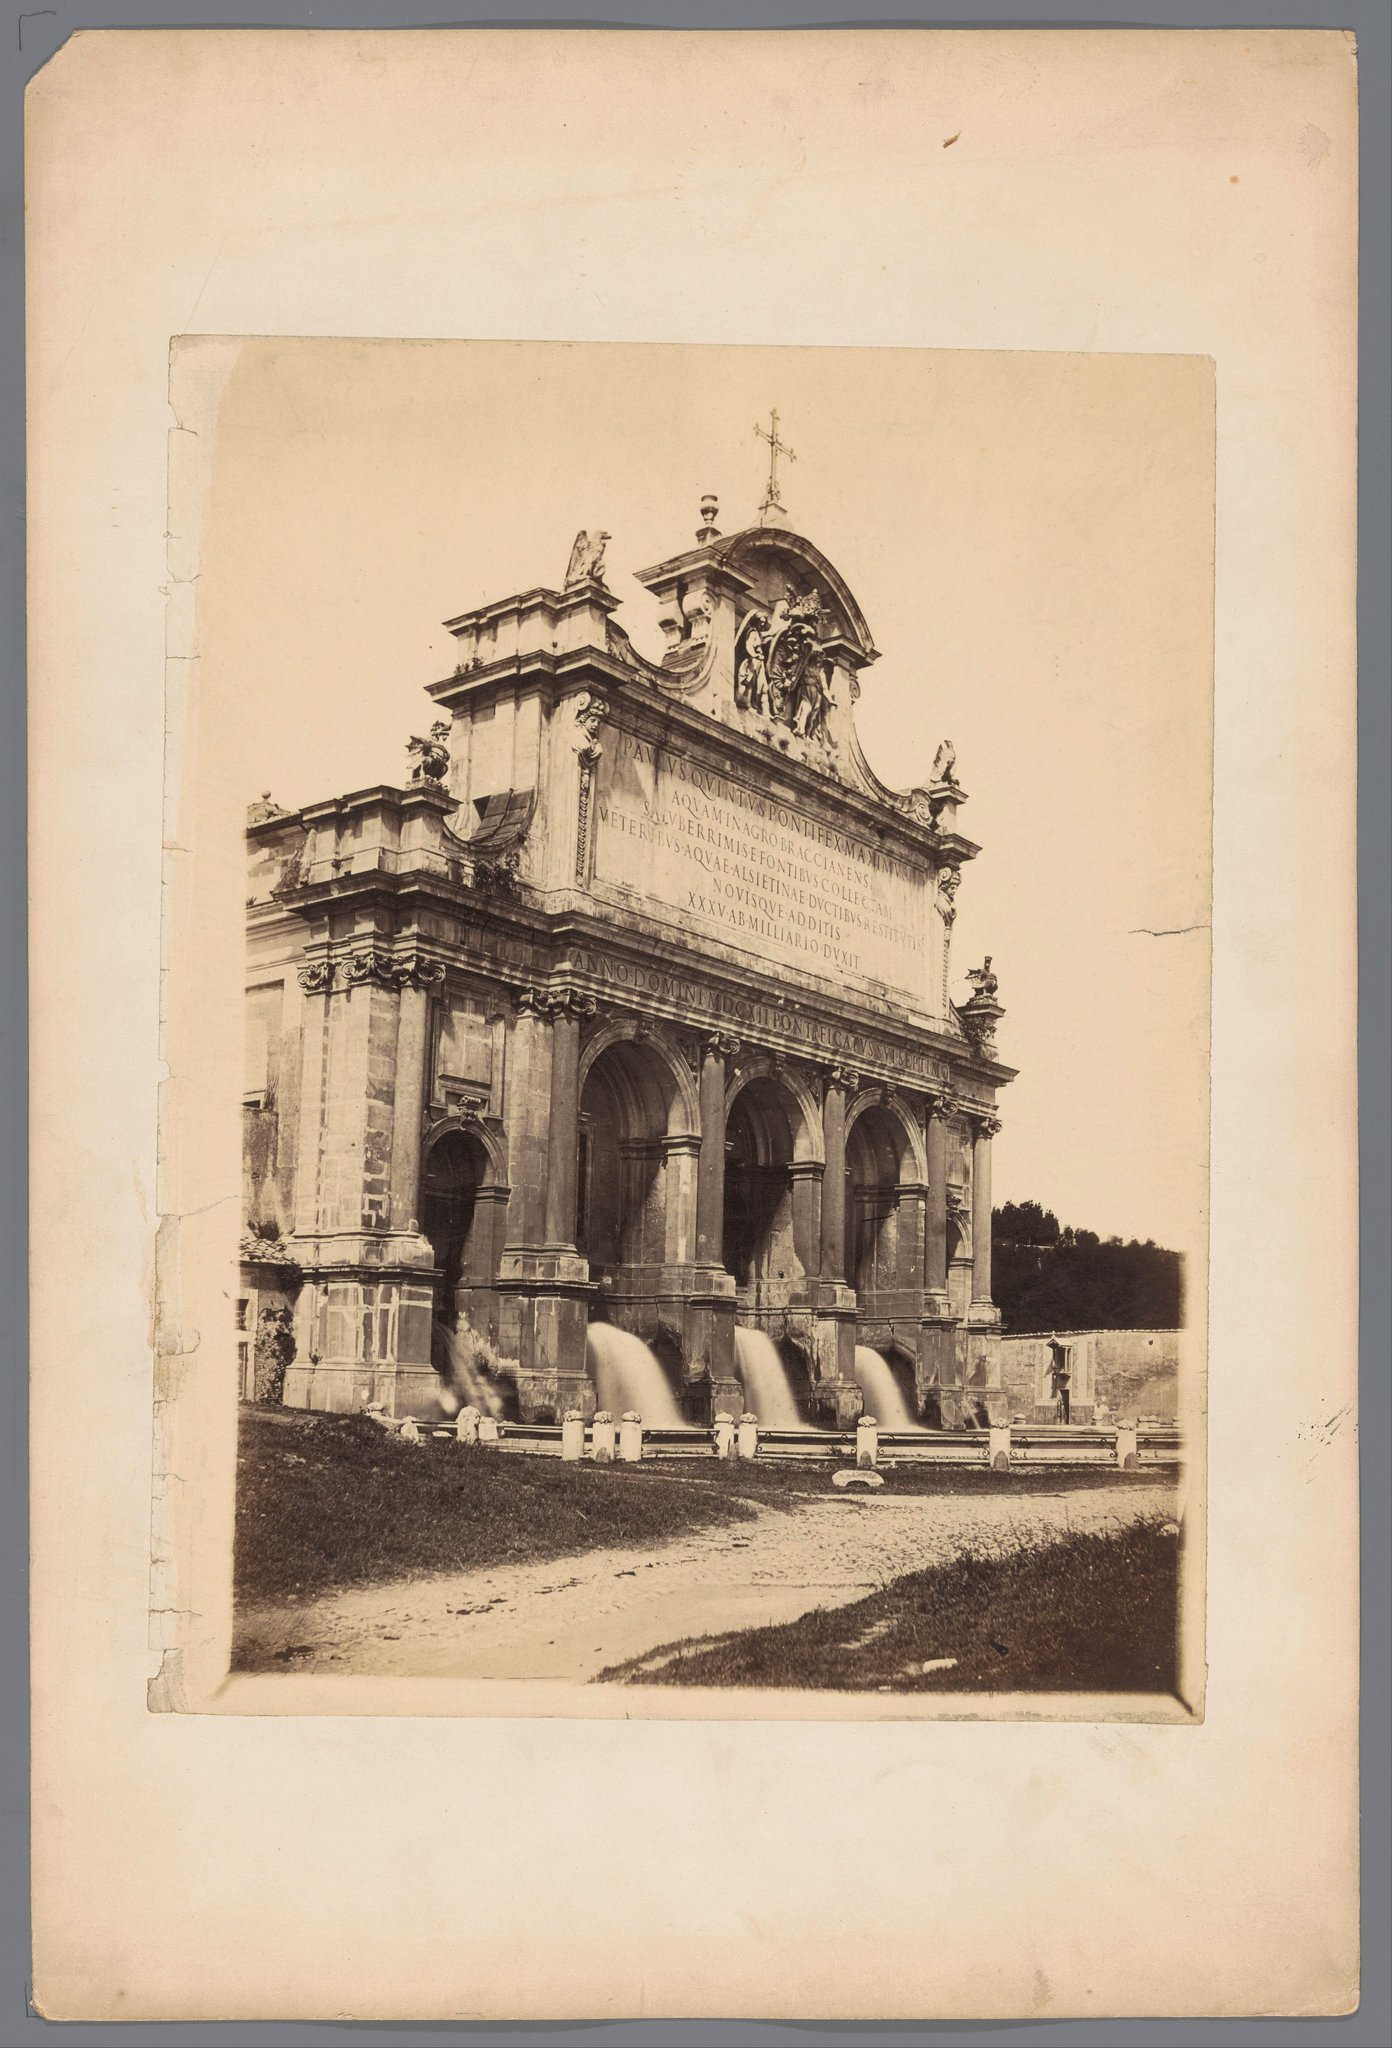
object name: photograph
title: Gezicht op de Fontana dell'Acqua Paola te Rome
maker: gustave eugène chauffourier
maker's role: fotograaf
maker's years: 1845-1919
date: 1875-1900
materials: photographic support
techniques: albumen print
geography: rome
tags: ornamental fountain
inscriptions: collector's mark: Lugt 3937